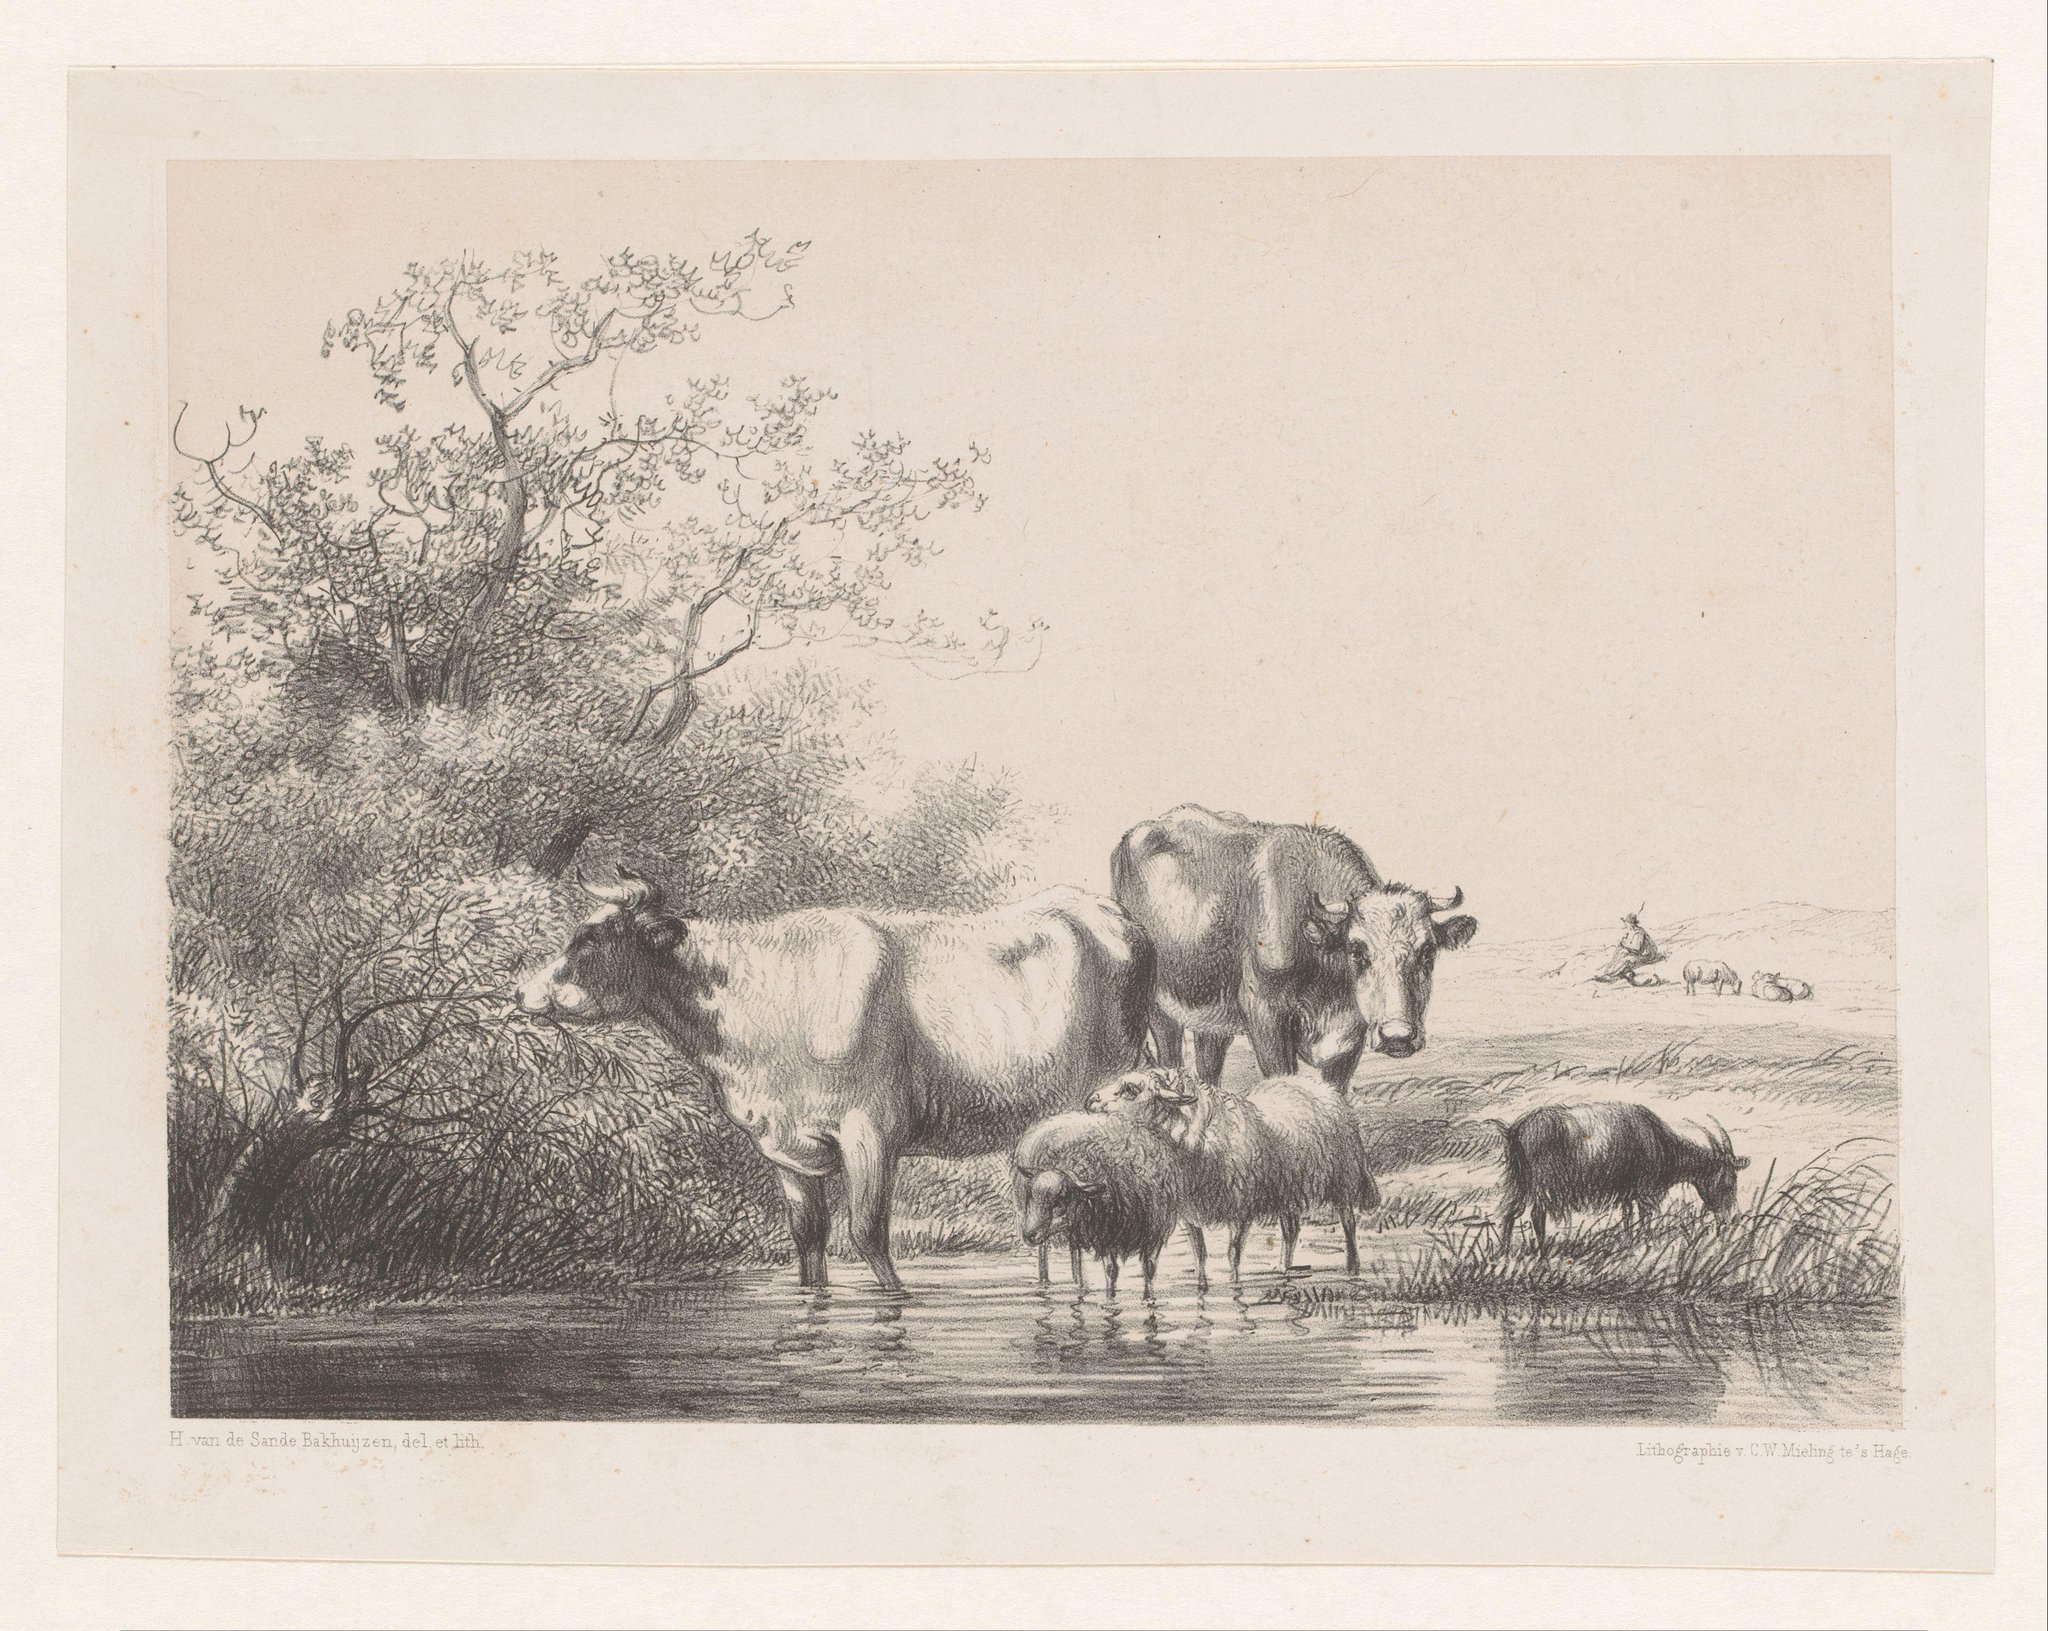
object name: print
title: Koeien en schapen in plas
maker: hendrikus van de sande bakhuyzen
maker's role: draughtsman, painter, print maker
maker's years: 1795-1860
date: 1847-1860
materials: paper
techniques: lithograph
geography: the hague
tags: cow, sheep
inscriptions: collector's mark: Lugt 2228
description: Twee koeien, twee schapen en een geit staan in een plas water met links bomen. In de achtergrond zit een herder met zijn schapen in het landschap.